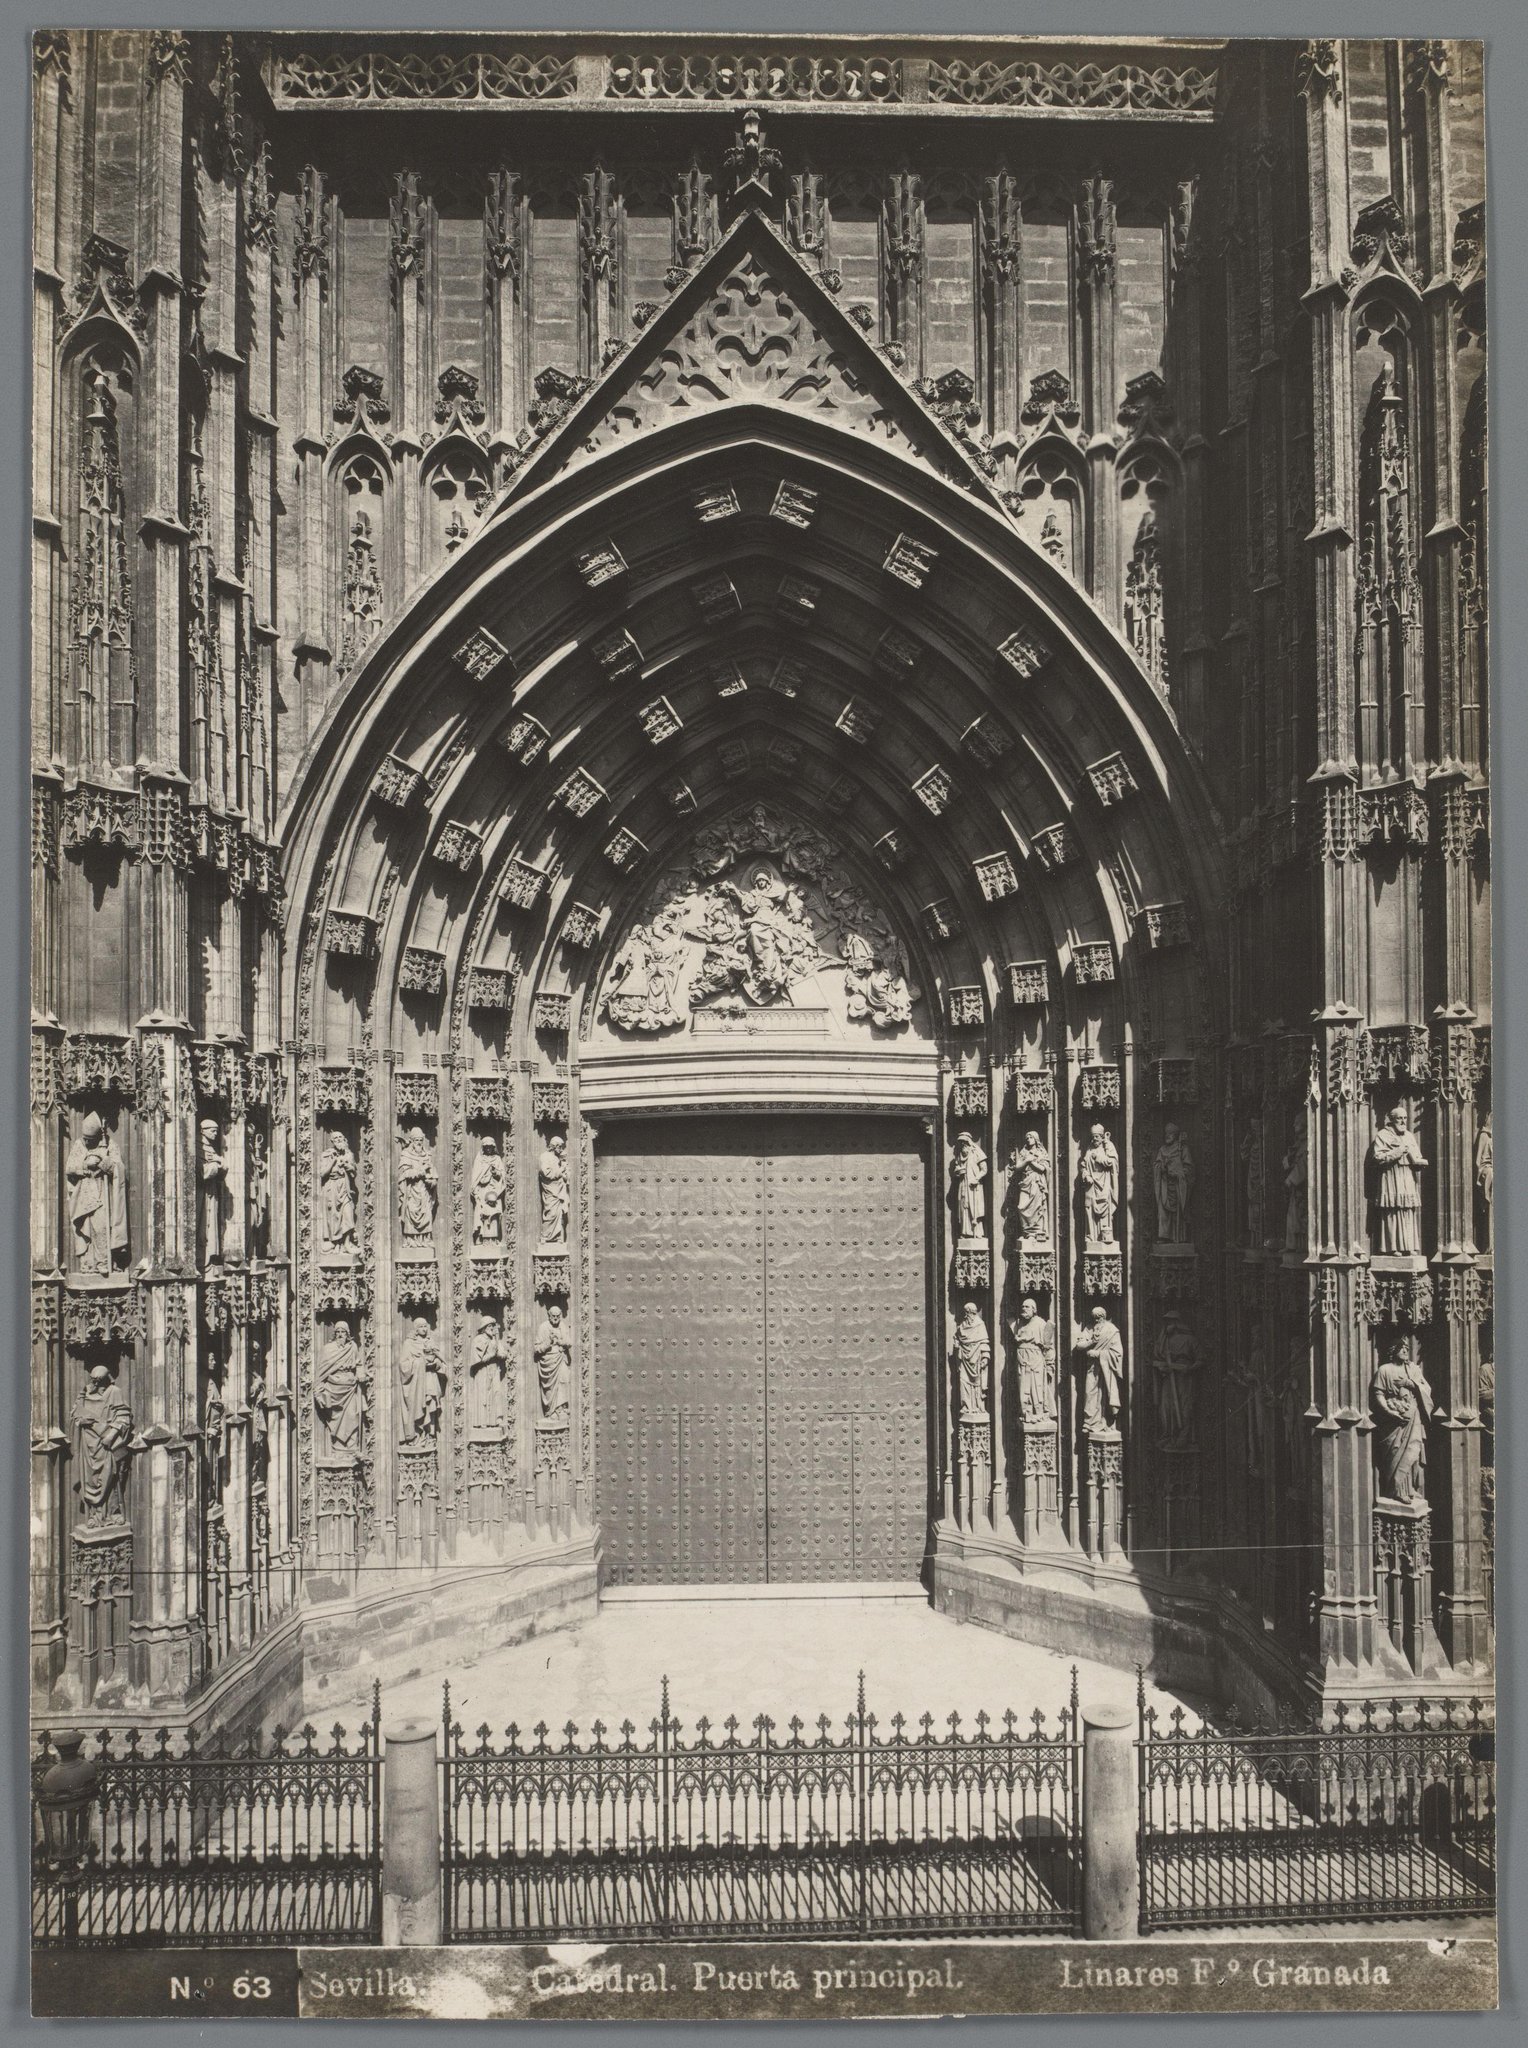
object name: photograph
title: Hoofdportaal van de Kathedraal van Sevilla, Spanje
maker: f. linares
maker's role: publisher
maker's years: 1870-1937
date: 1914-1937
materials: photographic support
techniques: gelatin silver print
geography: sevilla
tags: parts of church exterior and annexes: portal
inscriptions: number: ‘No. 63’